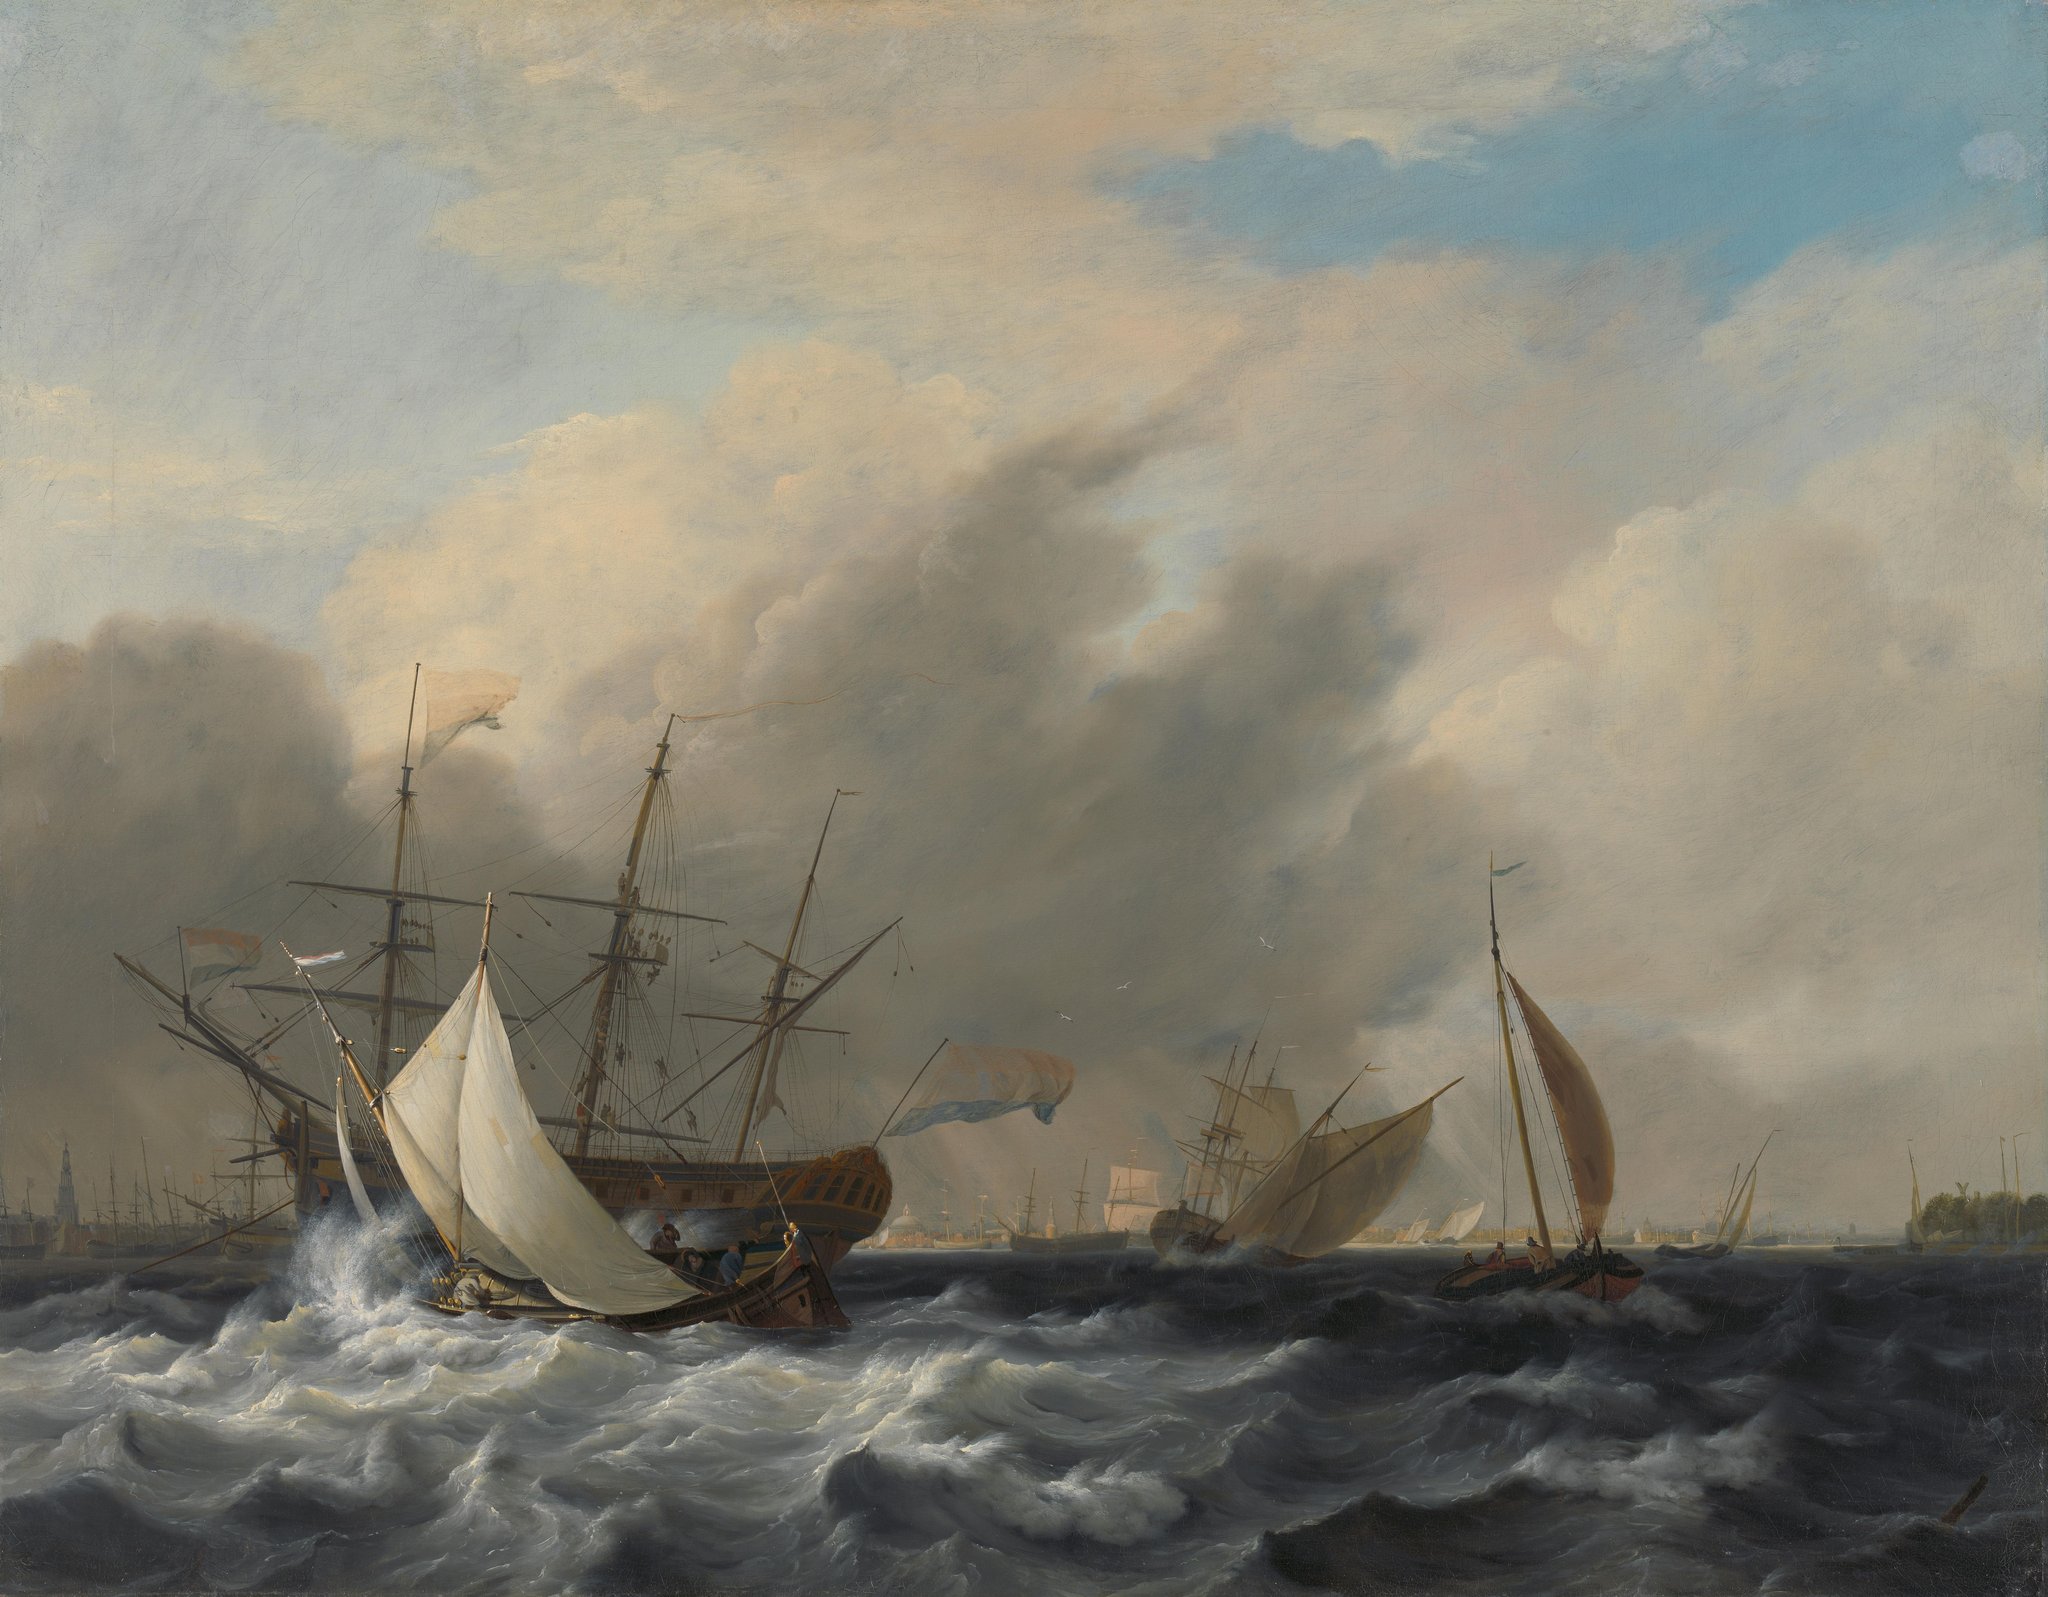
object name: painting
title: The Navy's Man-of-War 'Amsterdam'off the Westerlaag on Y at Amsterdam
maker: nicolaas baur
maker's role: draughtsman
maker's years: 1767-1820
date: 1807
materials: canvas, oil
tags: sailing-ship, sailing-boat, ship bound for the harbour, amsterdam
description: Het oorlogsschip 'Amsterdam' voor de Westerlaag op het IJ voor Amsterdam. Pendant van SK-A-1004.